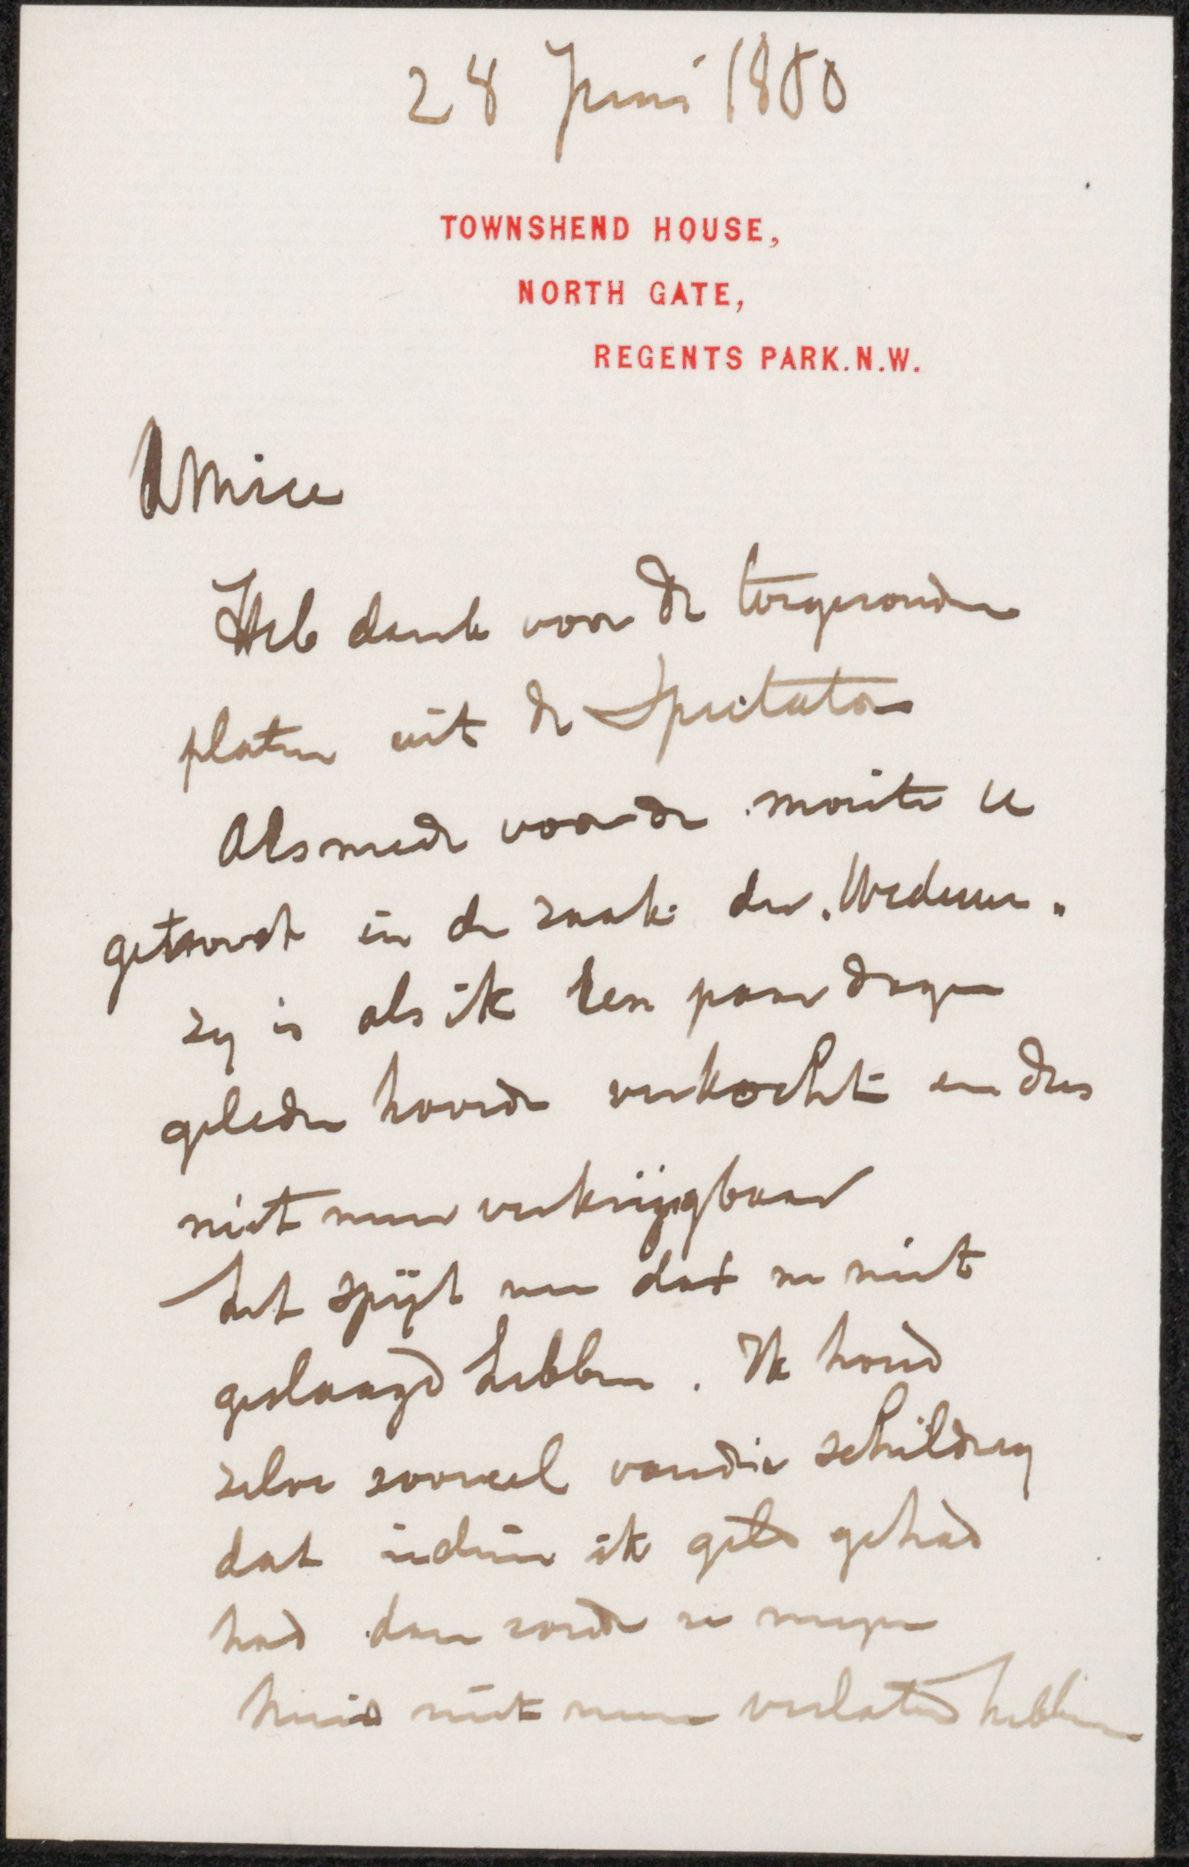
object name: letter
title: Brief aan Carel Vosmaer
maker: lourens alma tadema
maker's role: draughtsman, print maker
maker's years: 1836-1912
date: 1880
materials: ink, paper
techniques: pen, printing, writing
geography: london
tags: the hague, carel vosmaer, art trade, art shop, painting (including book-illumination, miniature-painting), money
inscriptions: watermark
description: De brief lijkt betrekking te hebben op het schilderij SK-A-2427.